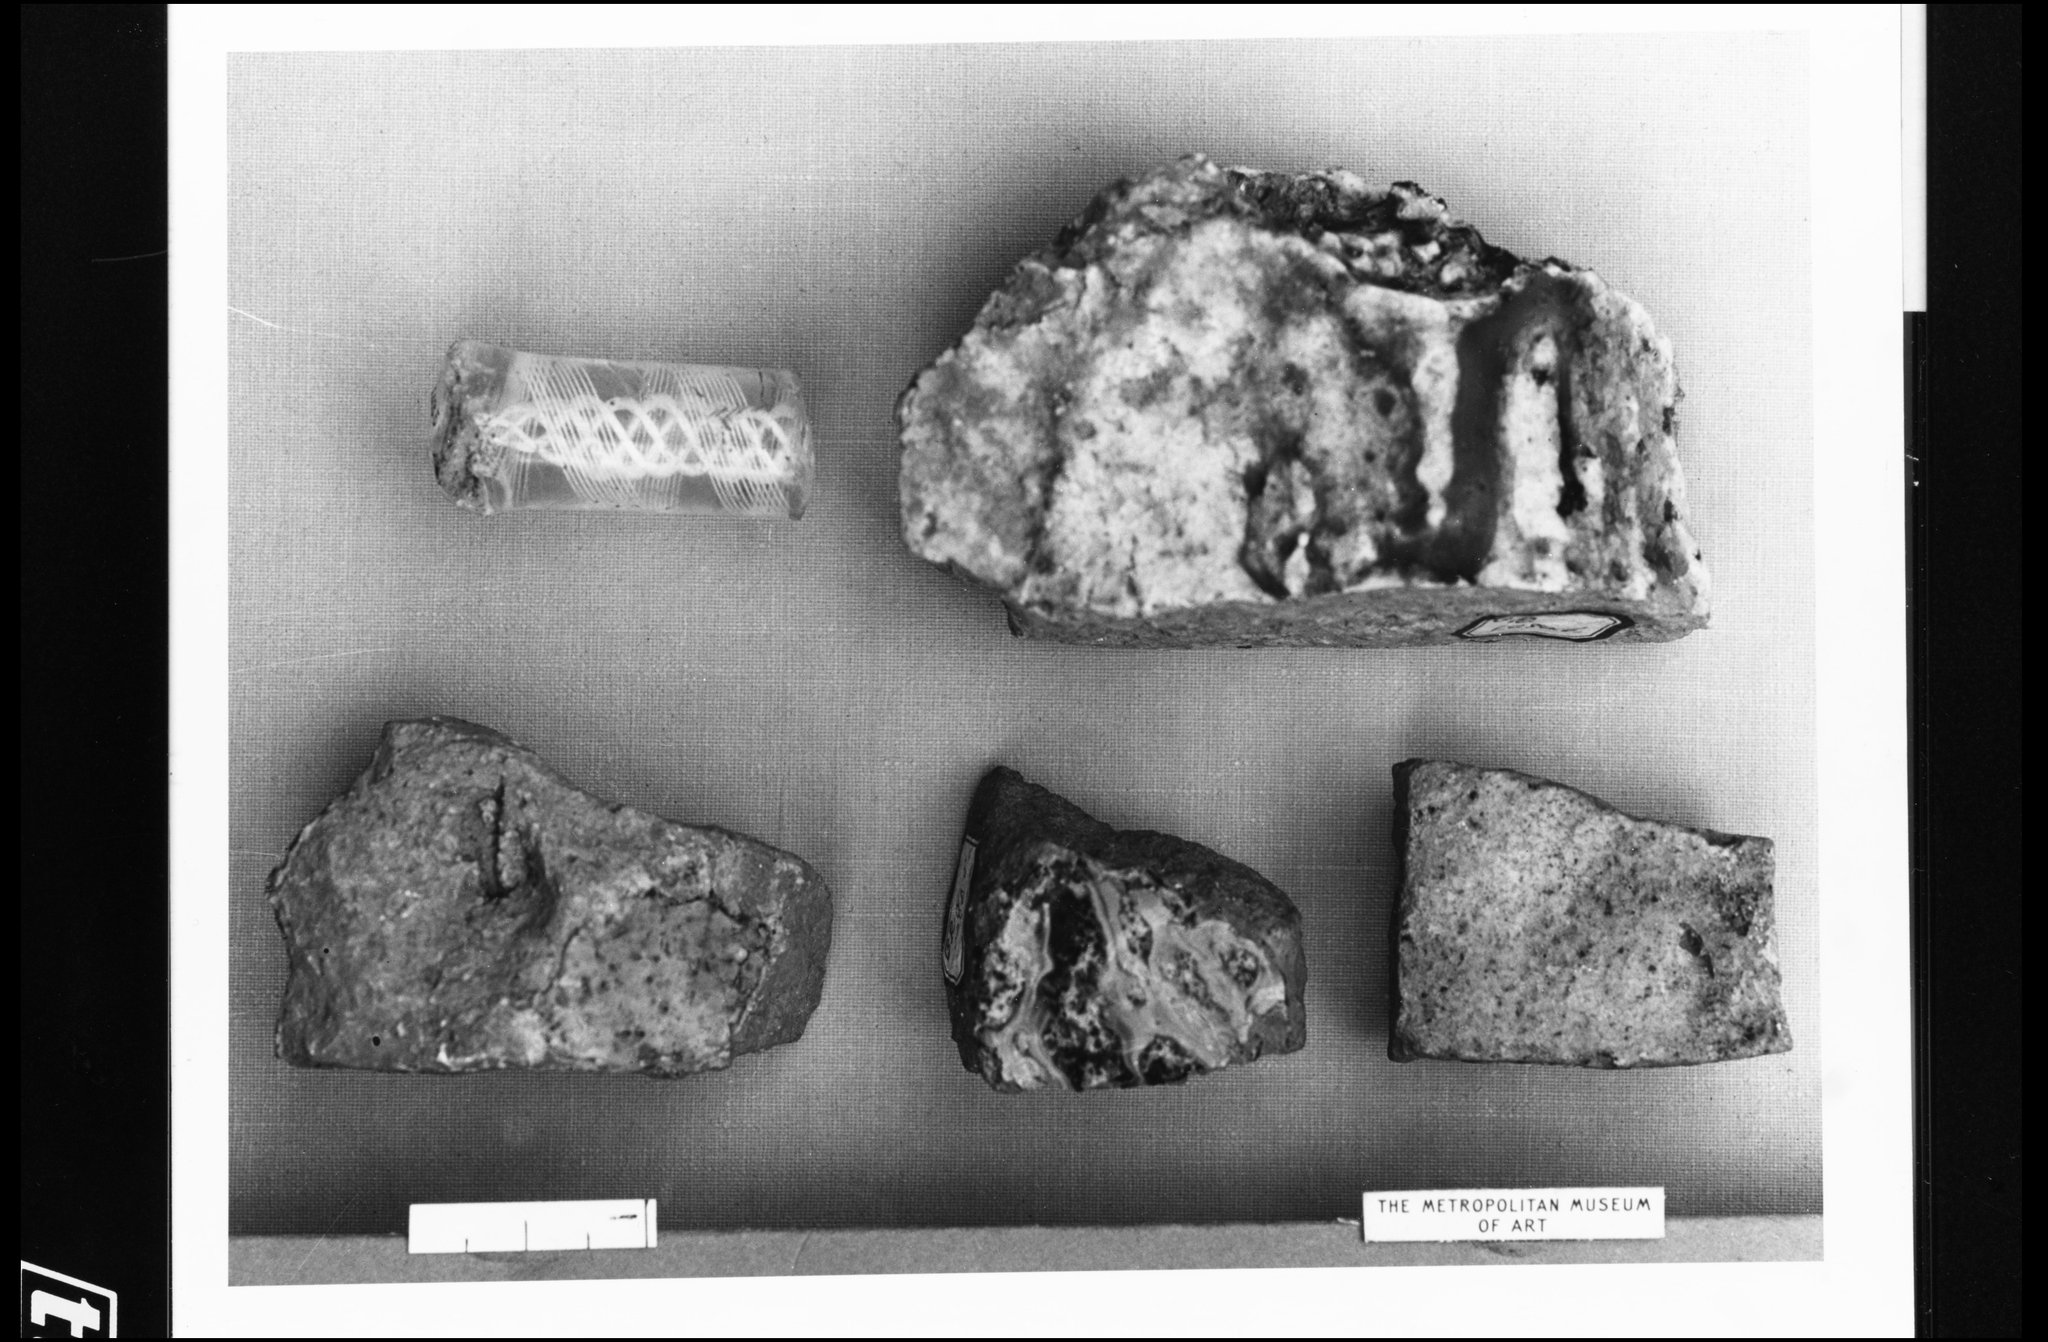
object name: fragment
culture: american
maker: stiegel's manheim factory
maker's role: maker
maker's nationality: american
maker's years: 1763-1774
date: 1763-1774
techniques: glassblowing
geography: united states